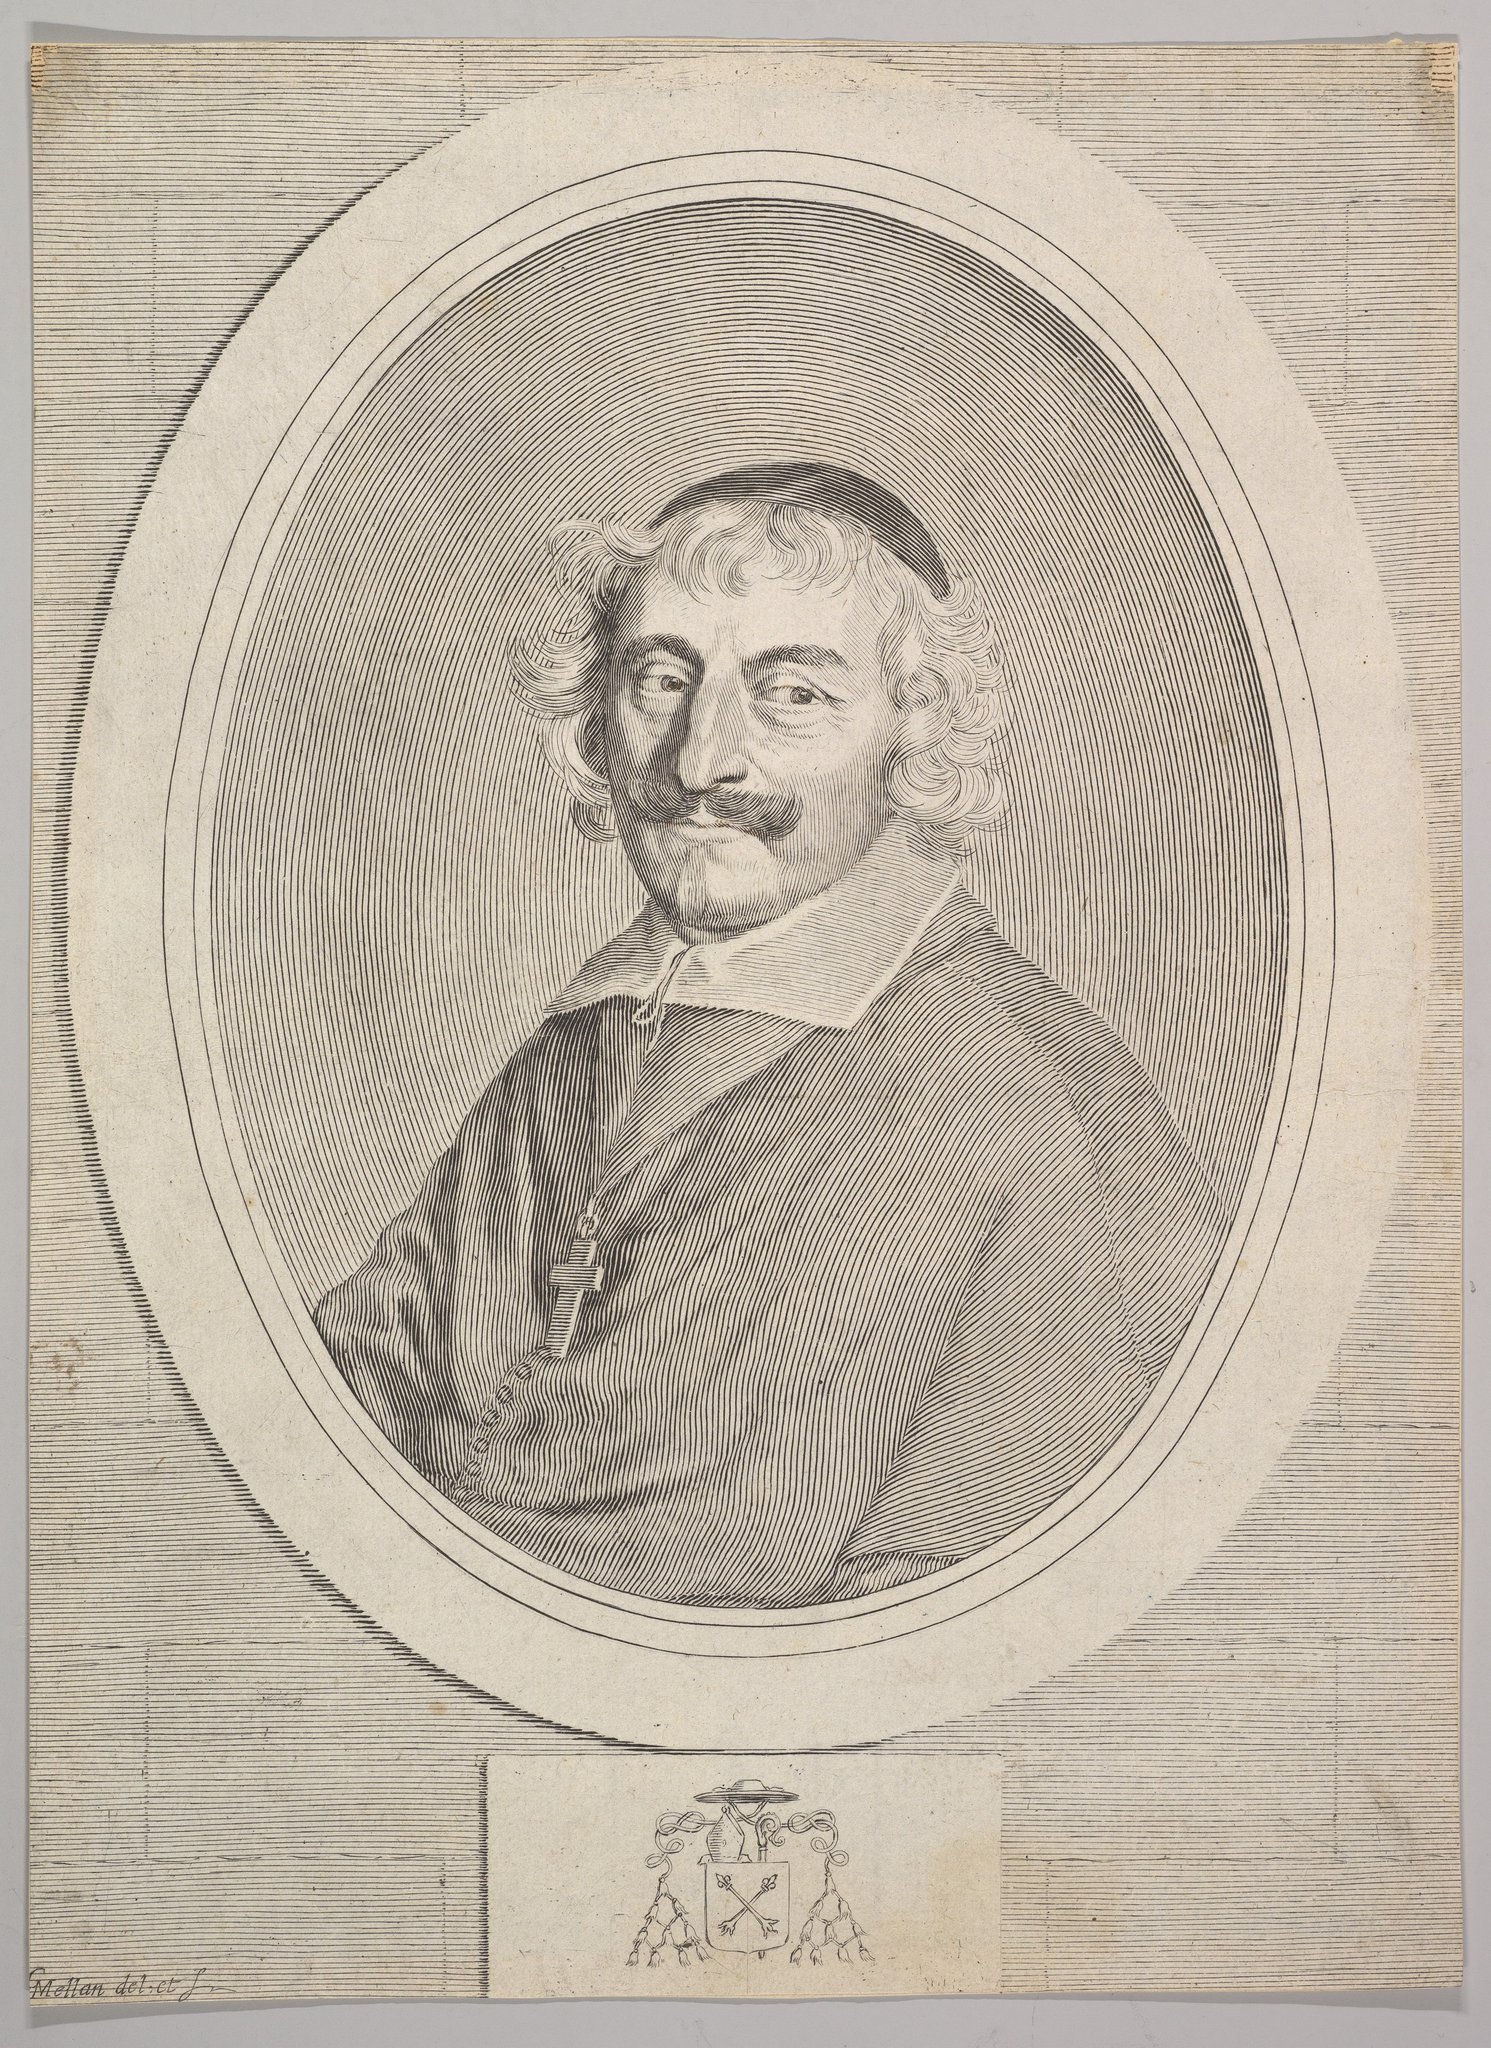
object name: print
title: Alphonse III Delbène, Bishop of Orléans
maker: claude mellan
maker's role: artist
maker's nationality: french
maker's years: 1598-1688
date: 1646-1665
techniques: engraving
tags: men,portraits,bishops